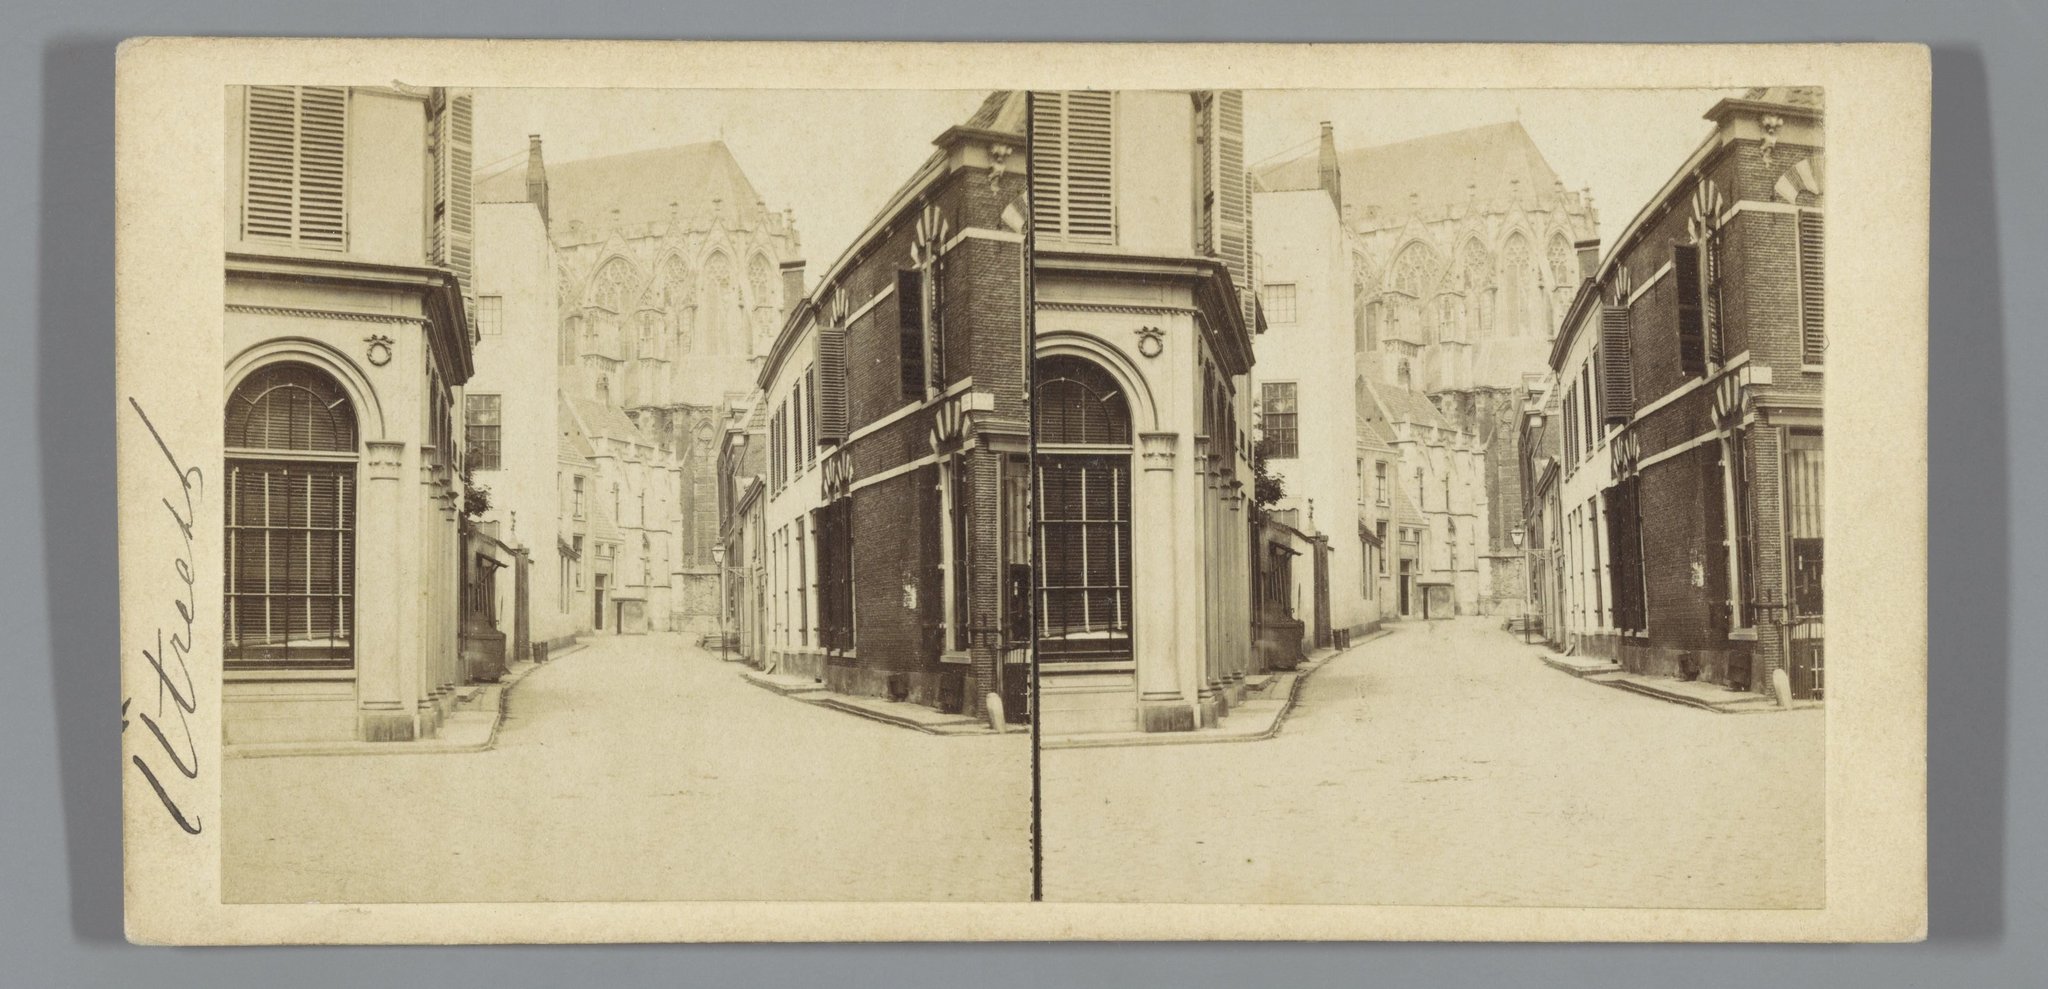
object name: stereograph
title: Utrecht, Domkerk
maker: pieter oosterhuis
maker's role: draughtsman, print maker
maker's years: 1816-1885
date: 1859-1865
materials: cardboard, paper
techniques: albumen print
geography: utrecht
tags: church (exterior), street, utrecht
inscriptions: inscription: ‘Utrecht’, number: ‘No. 6’, number: ‘59’, inscription: ‘P. Domkerk’, number: ‘7’